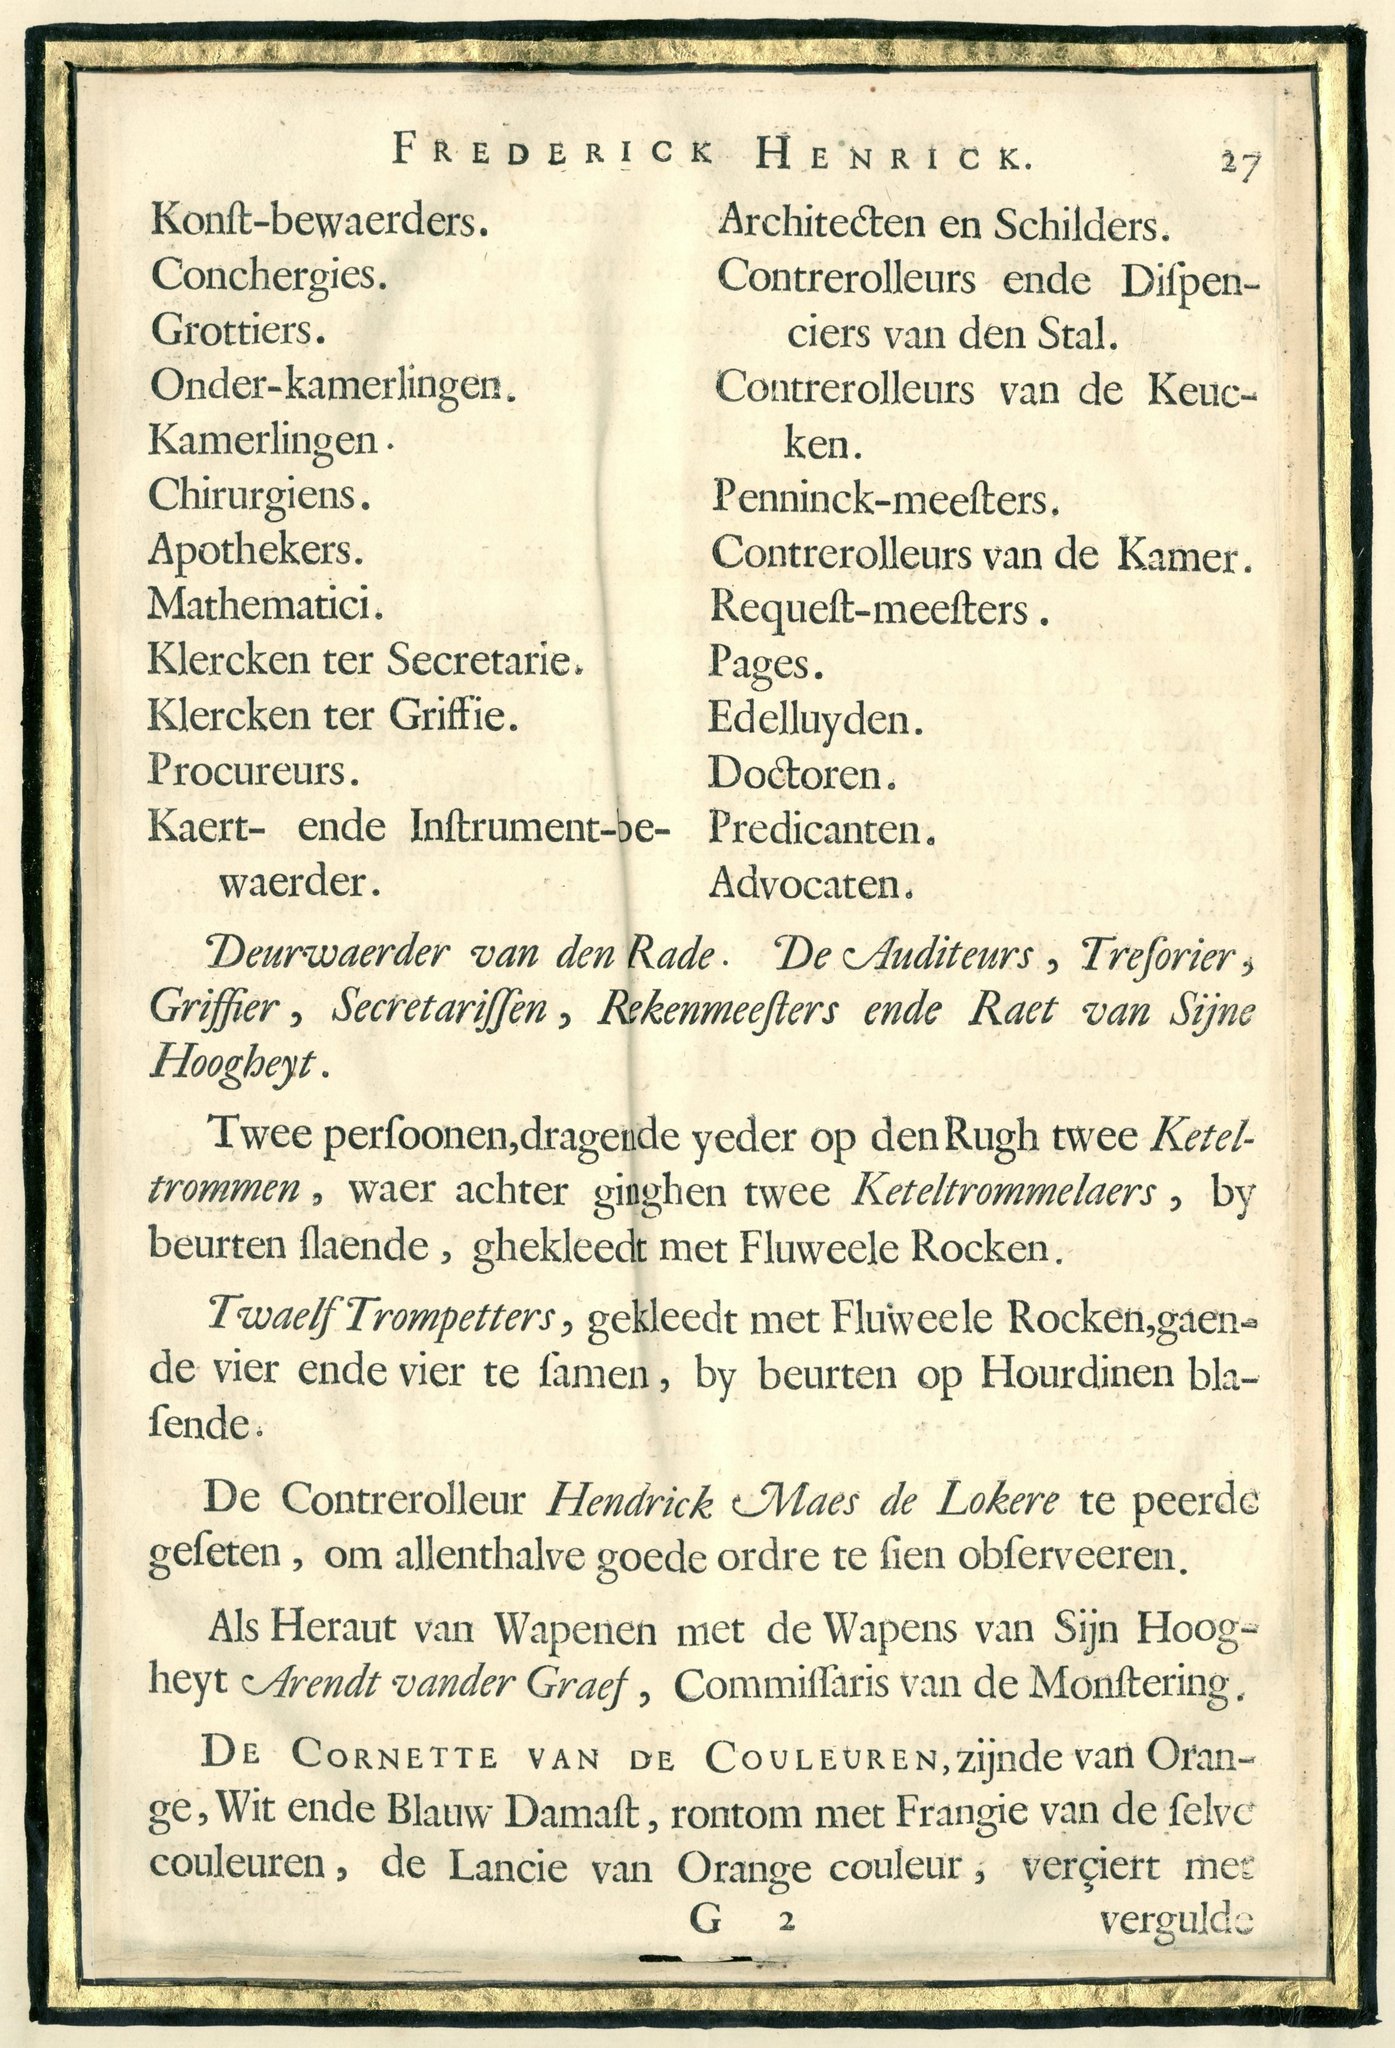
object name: text sheet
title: Begraeffenisse van syne hoogheyt Frederick Henrick. Luxe ingekleurde uitgave van de prenten van de begrafenisstoet van Frederik Hendrik in 1647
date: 1651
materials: paint, paper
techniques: letterpress printing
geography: amsterdam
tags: delft, frederick henry (prince of orange)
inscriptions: date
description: Pagina 27 van de beschrijving van de begrafenis van Frederik Hendrik. Blad uitgeknipt, versierd met goud en ingeplakt in de luxe editie uit ca. 1755 van het boek 'Begraeffenisse van syne hoogheyt Frederick Henrick' van Pieter Post, uitgegeven te Amsterdam in 1651.